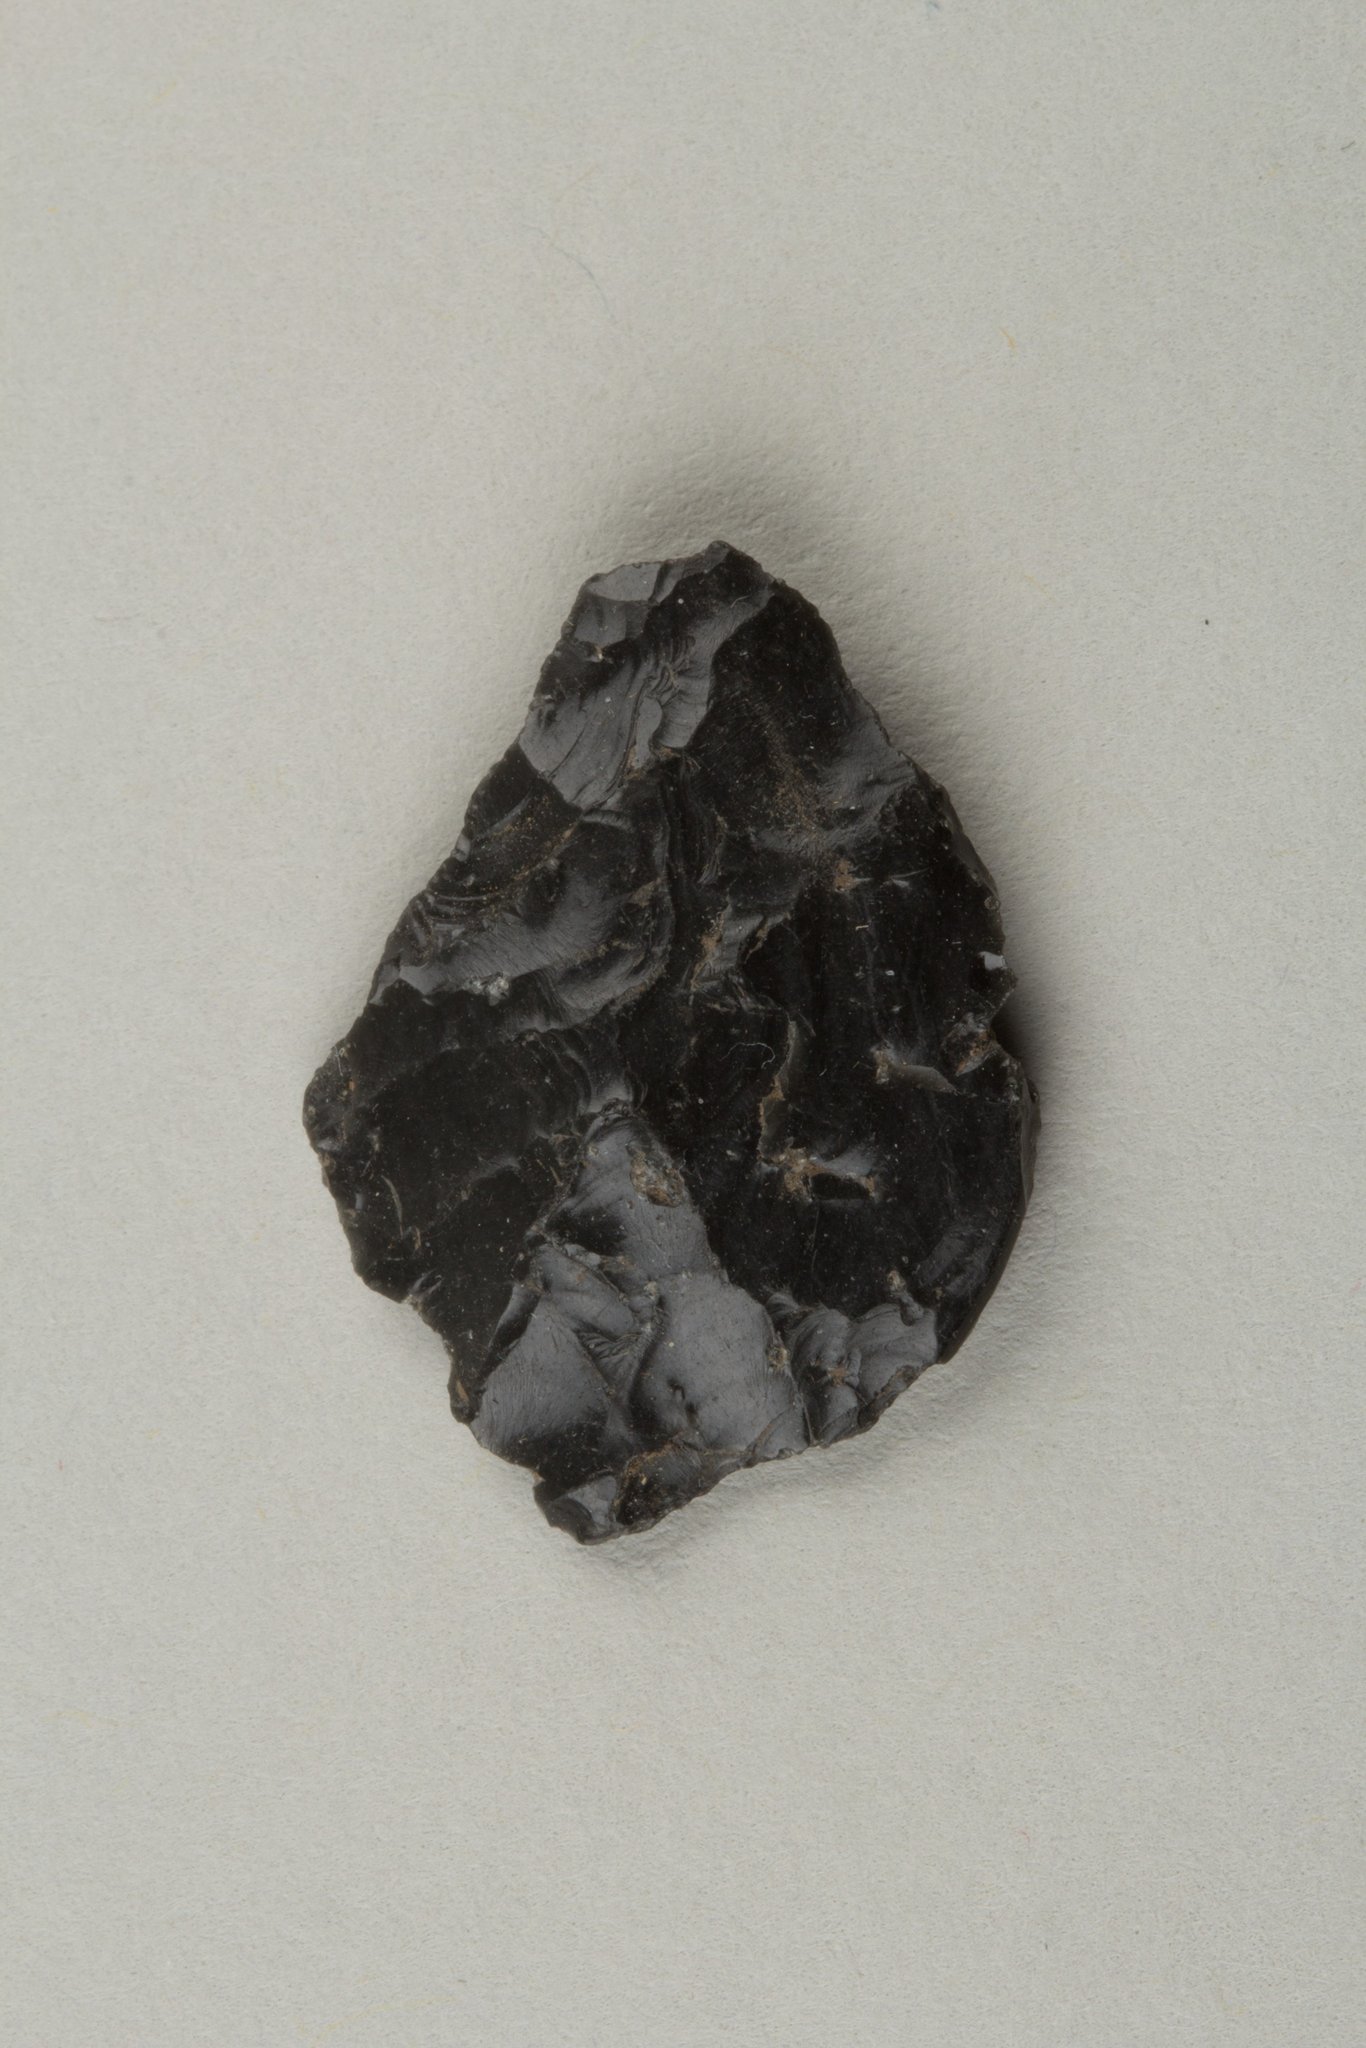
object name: arrowhead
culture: japanese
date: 1500-1000 BCE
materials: stone